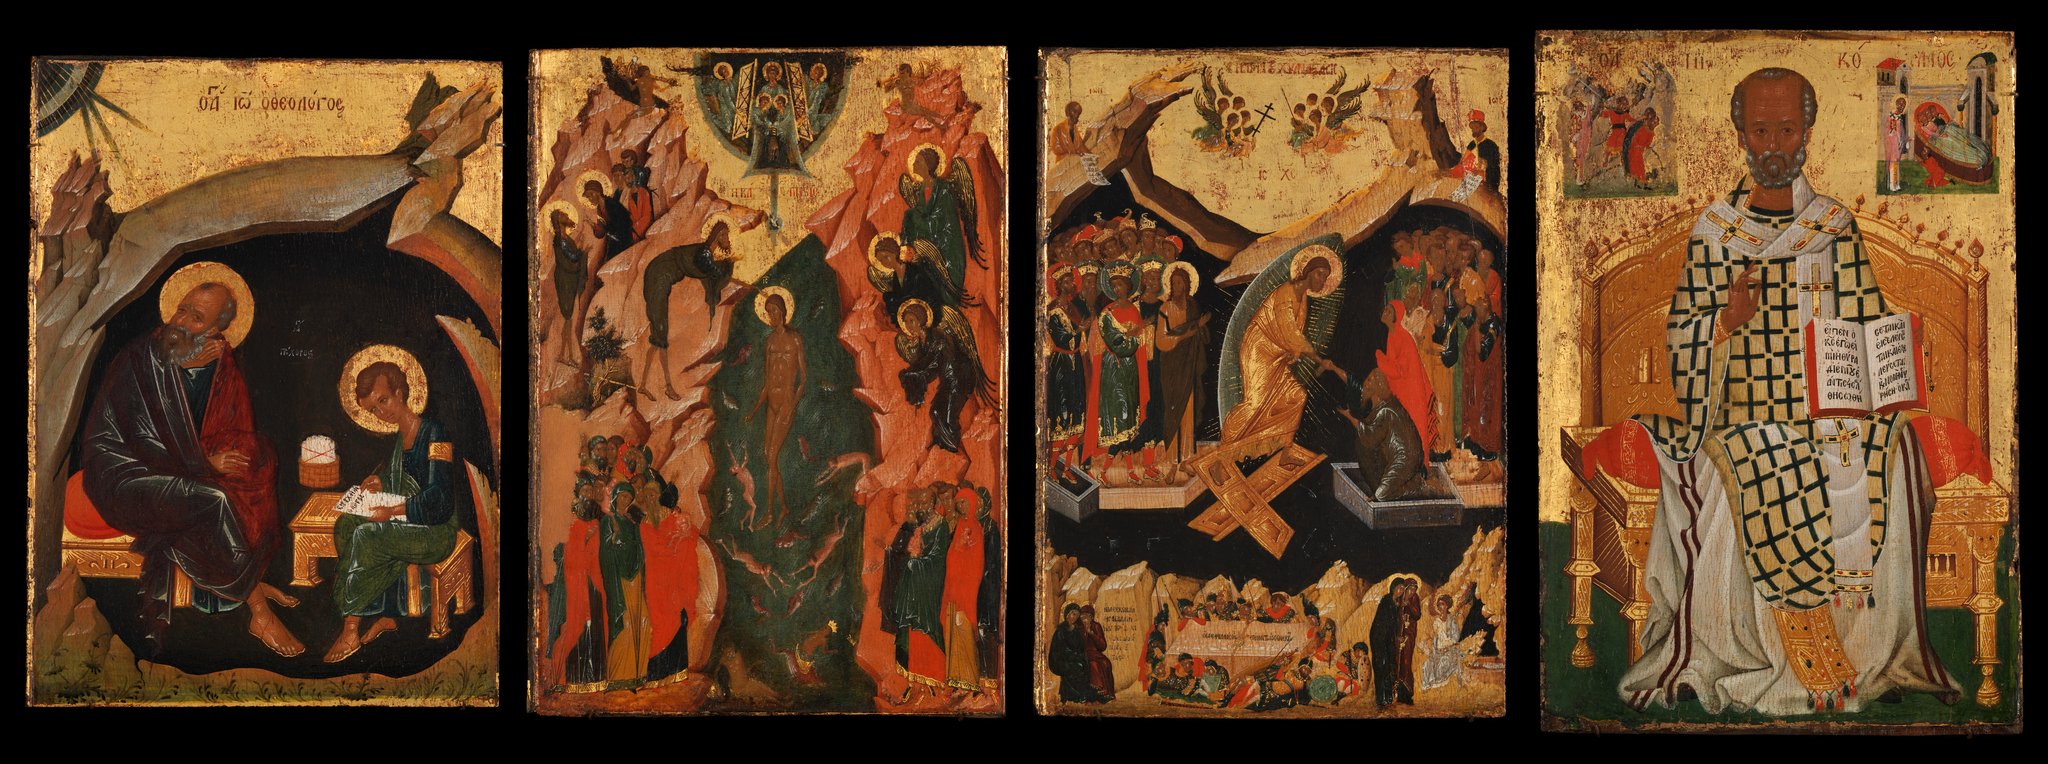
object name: icon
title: Four Icons from a Pair of Doors (Panels), possibly part of a Polyptych: John the Theologian and Prochoros, the Baptism (Epiphany), Harrowing of Hell (Anastasis), and Saint Nicholas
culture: byzantine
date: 1401-1433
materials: gold, paint, wood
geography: crete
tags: bishops,baptism of christ,saints,writing